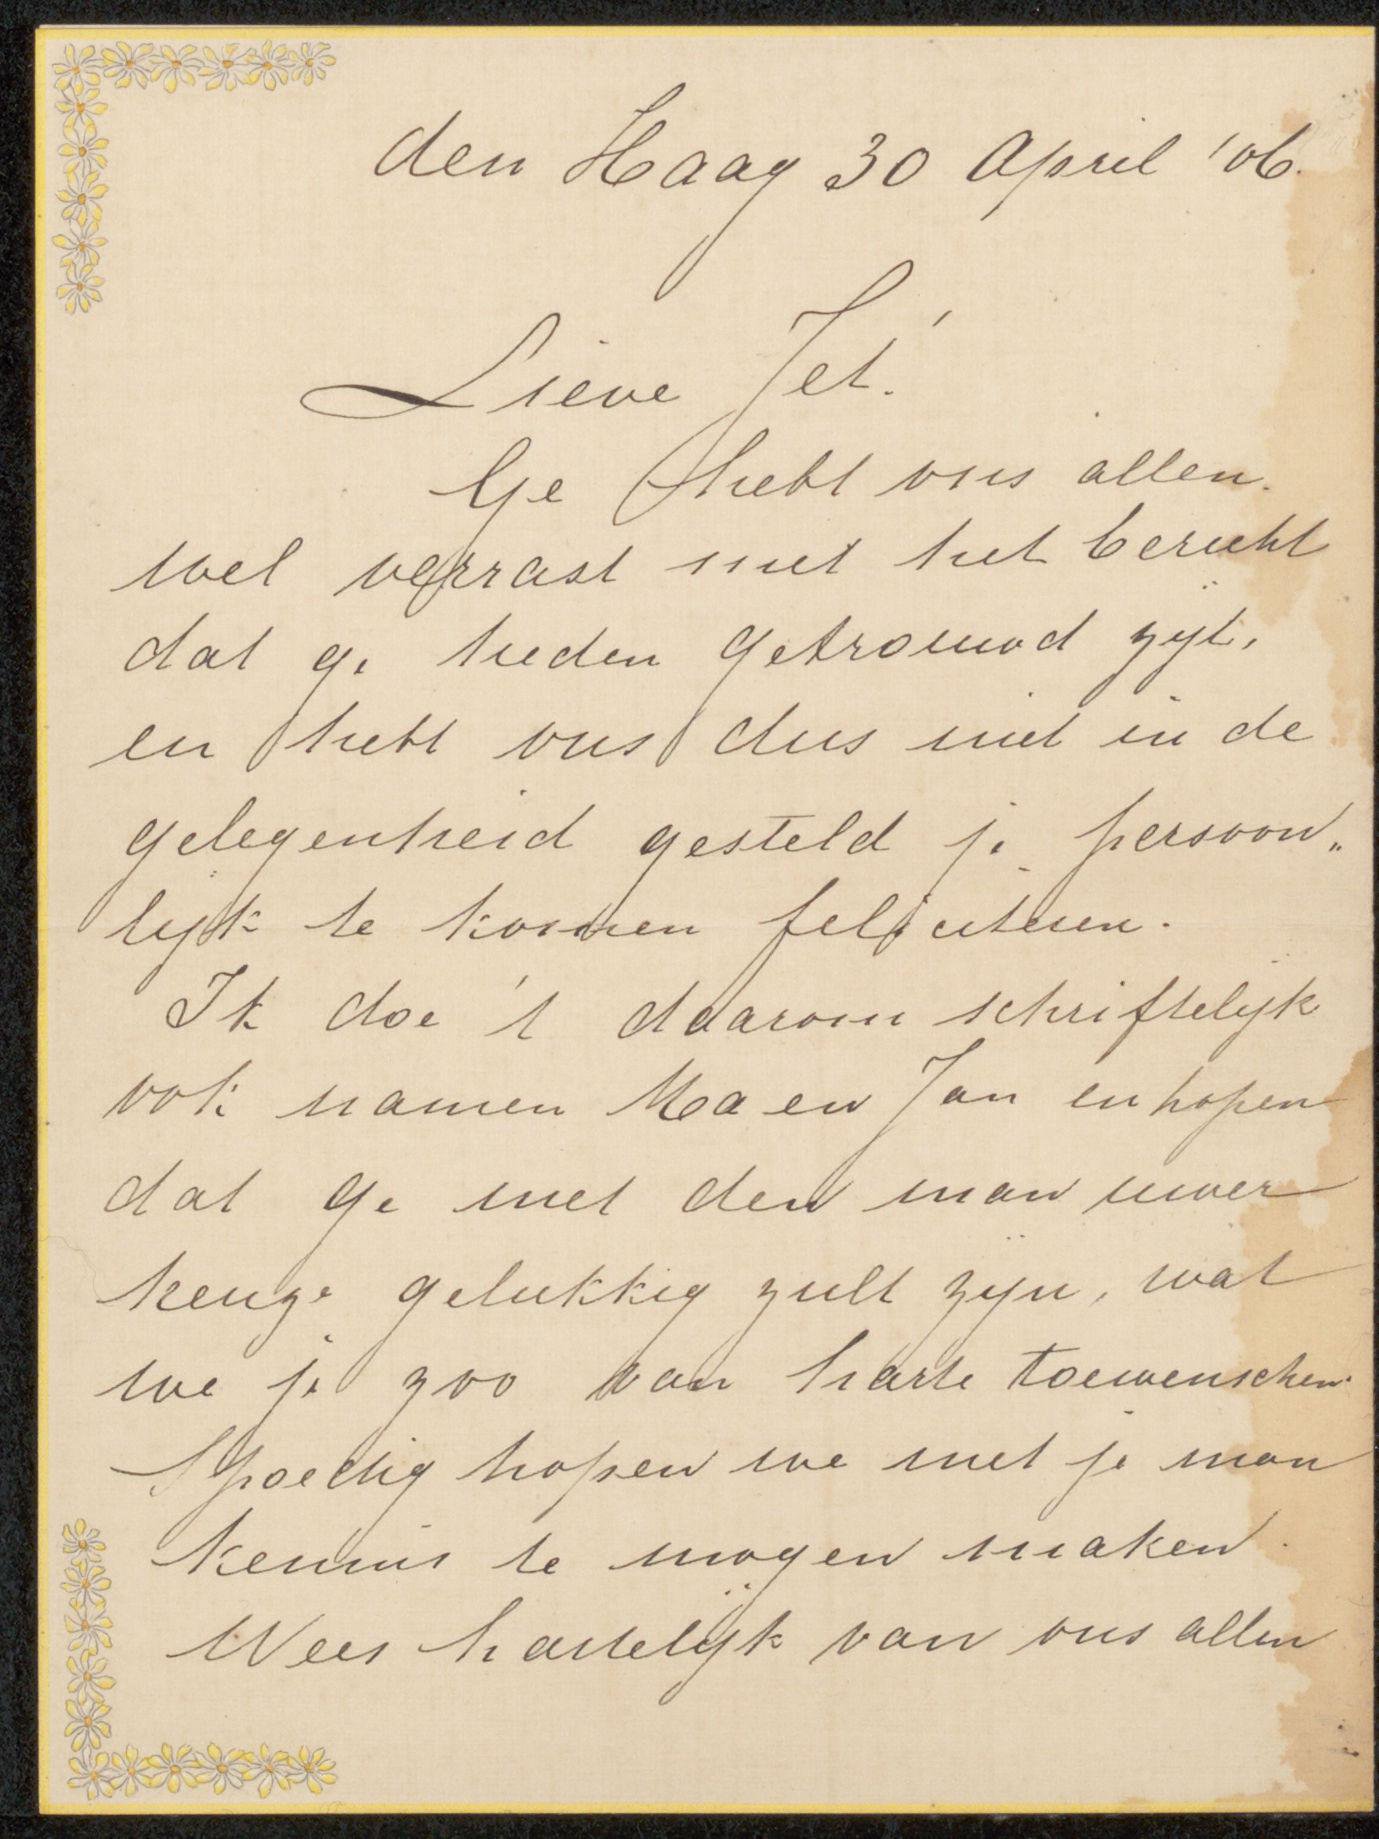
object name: letter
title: Brief aan Henriette Wilhelmina van Baak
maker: lien van delden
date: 1930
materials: ink, paper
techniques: pen, writing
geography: the hague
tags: henriette wilhelmina van baak, gerard delfgaauw, painter, draughtsman, philip zilcken, family life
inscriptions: collector's mark: ‘RPK’